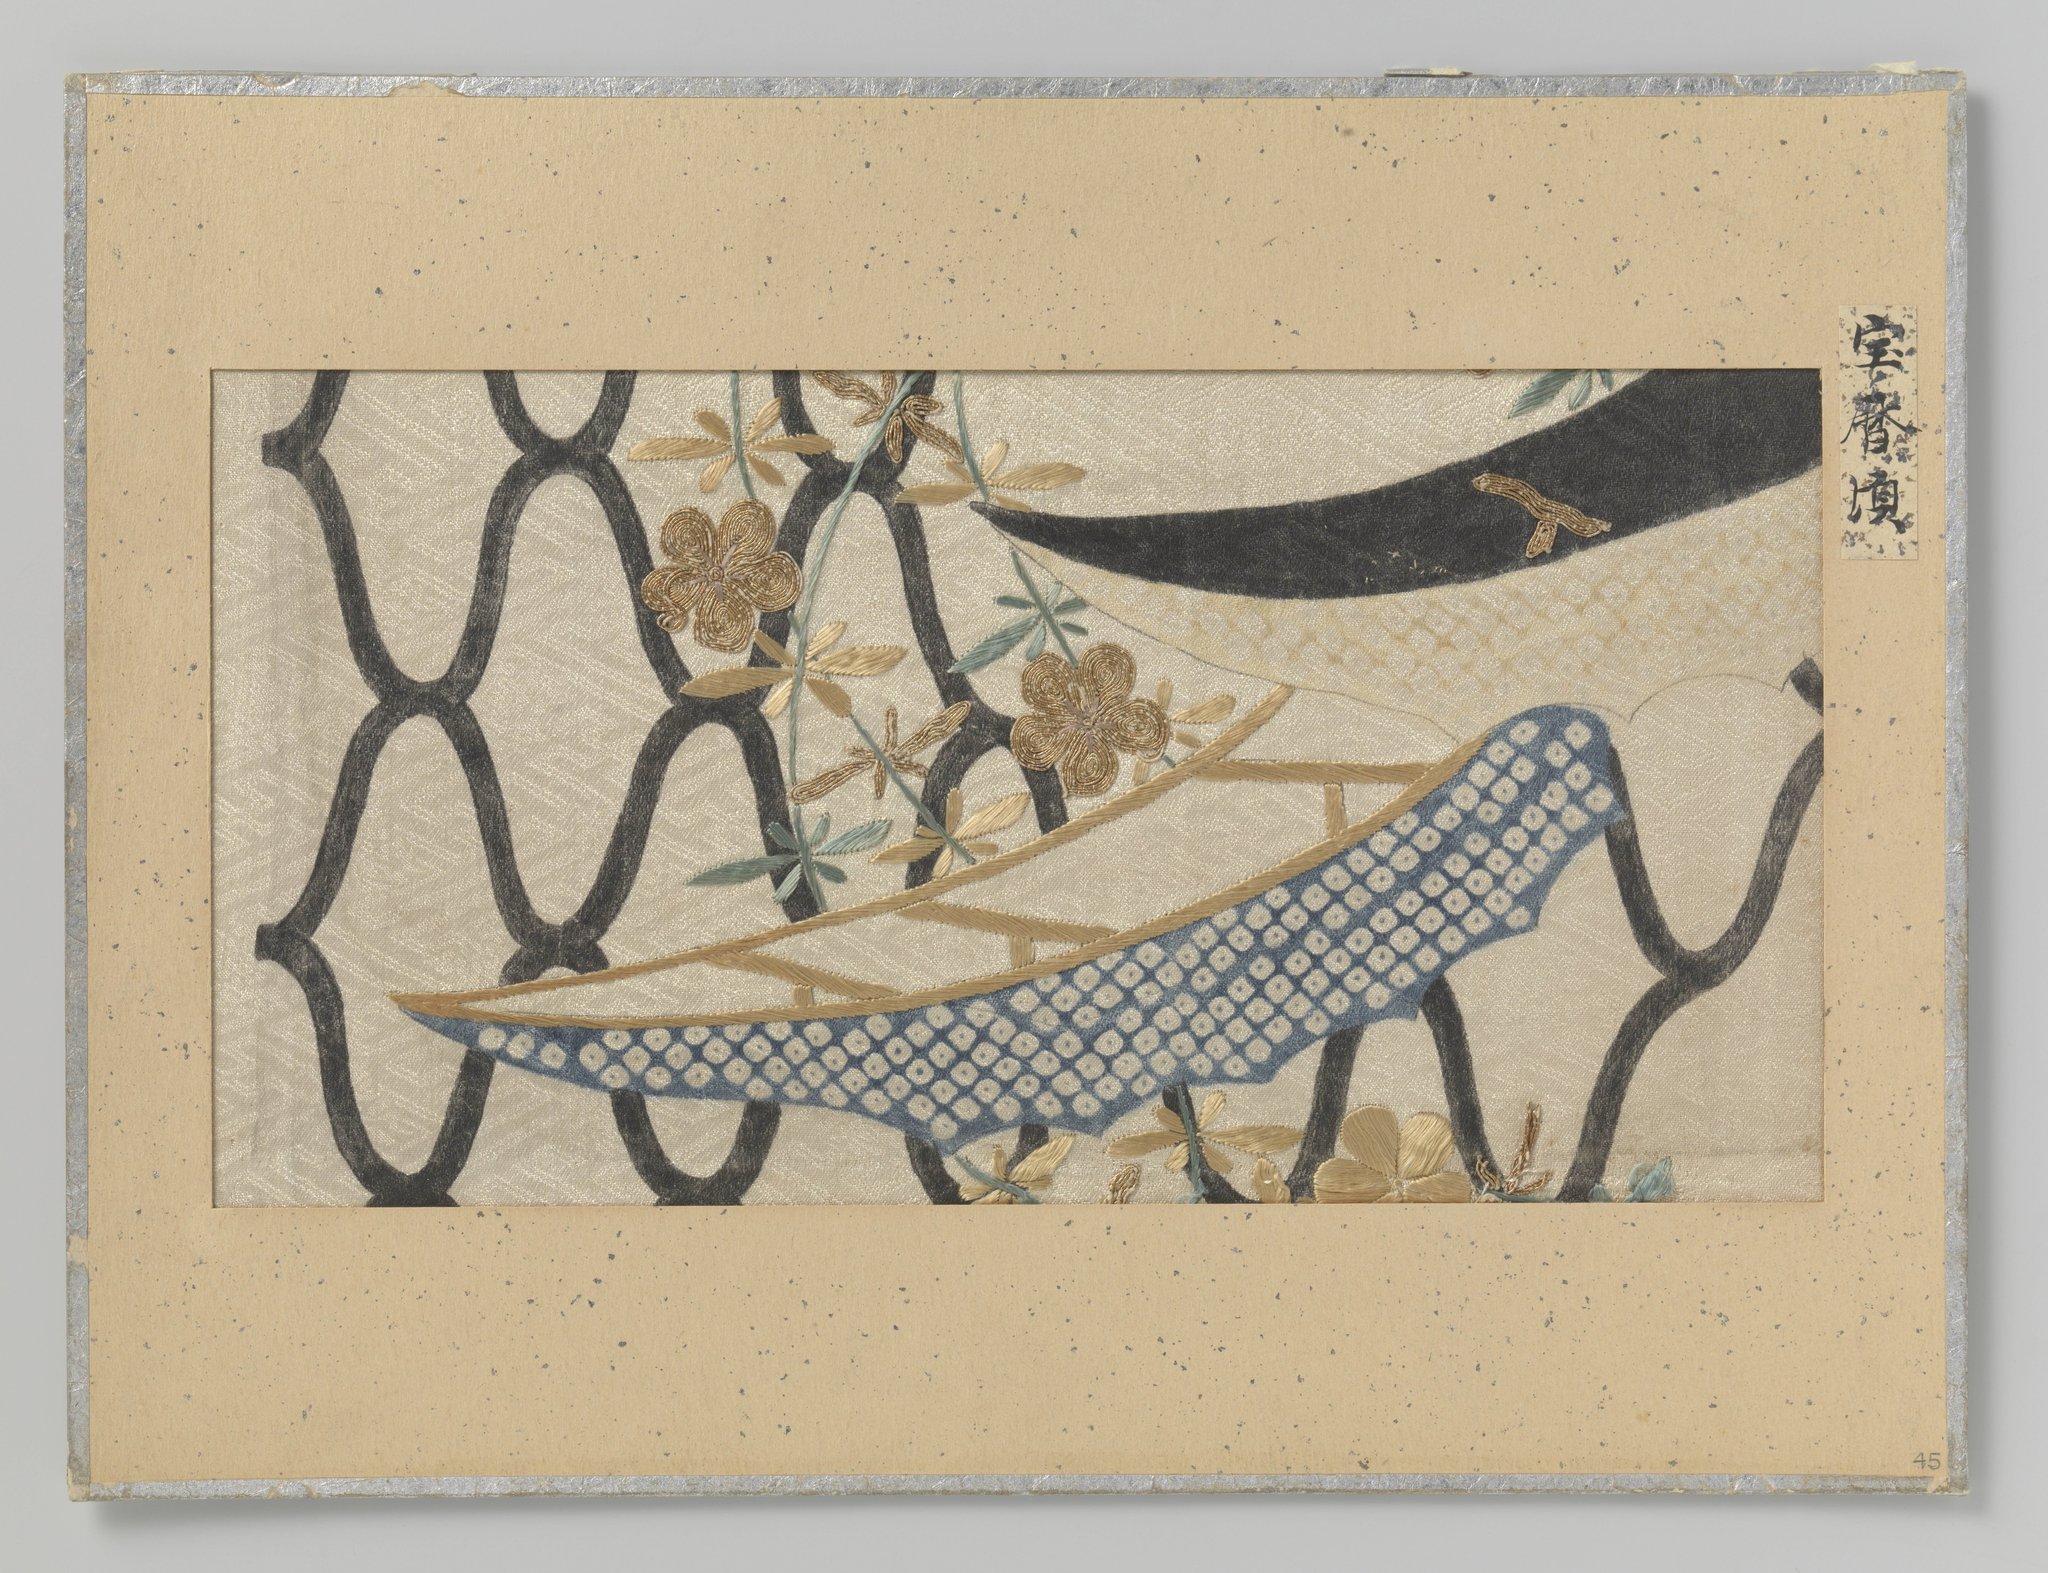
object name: fragment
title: Fragment textiel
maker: Anonymous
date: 1751-1764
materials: silk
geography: japan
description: Textielfragment, borduursel en druk van twee bootjes en planten op damastachtergrond.